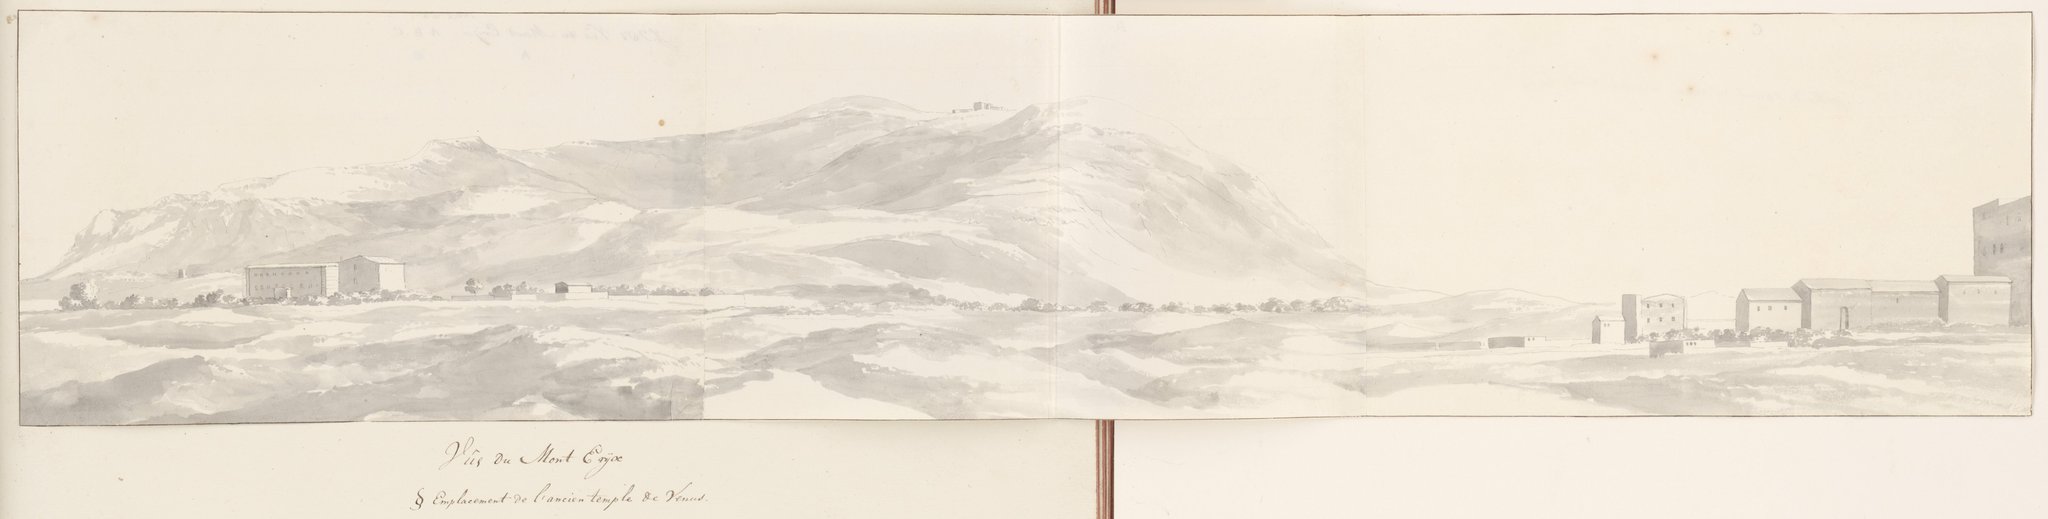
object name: drawing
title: Panorama met berg Eryx en vlakte, locatie van de oude Venus tempel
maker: louis ducros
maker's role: draughtsman, print maker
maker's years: 1748-1810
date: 1778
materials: chalk, paper, watercolor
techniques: brush, pen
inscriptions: inscription: ‘No 287 Vue du Mont Eryx & Emplacement de l'ancien temple de Venus’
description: Tekening uit het album 'Voyage en Italie, en Sicile et à Malte', 1778.